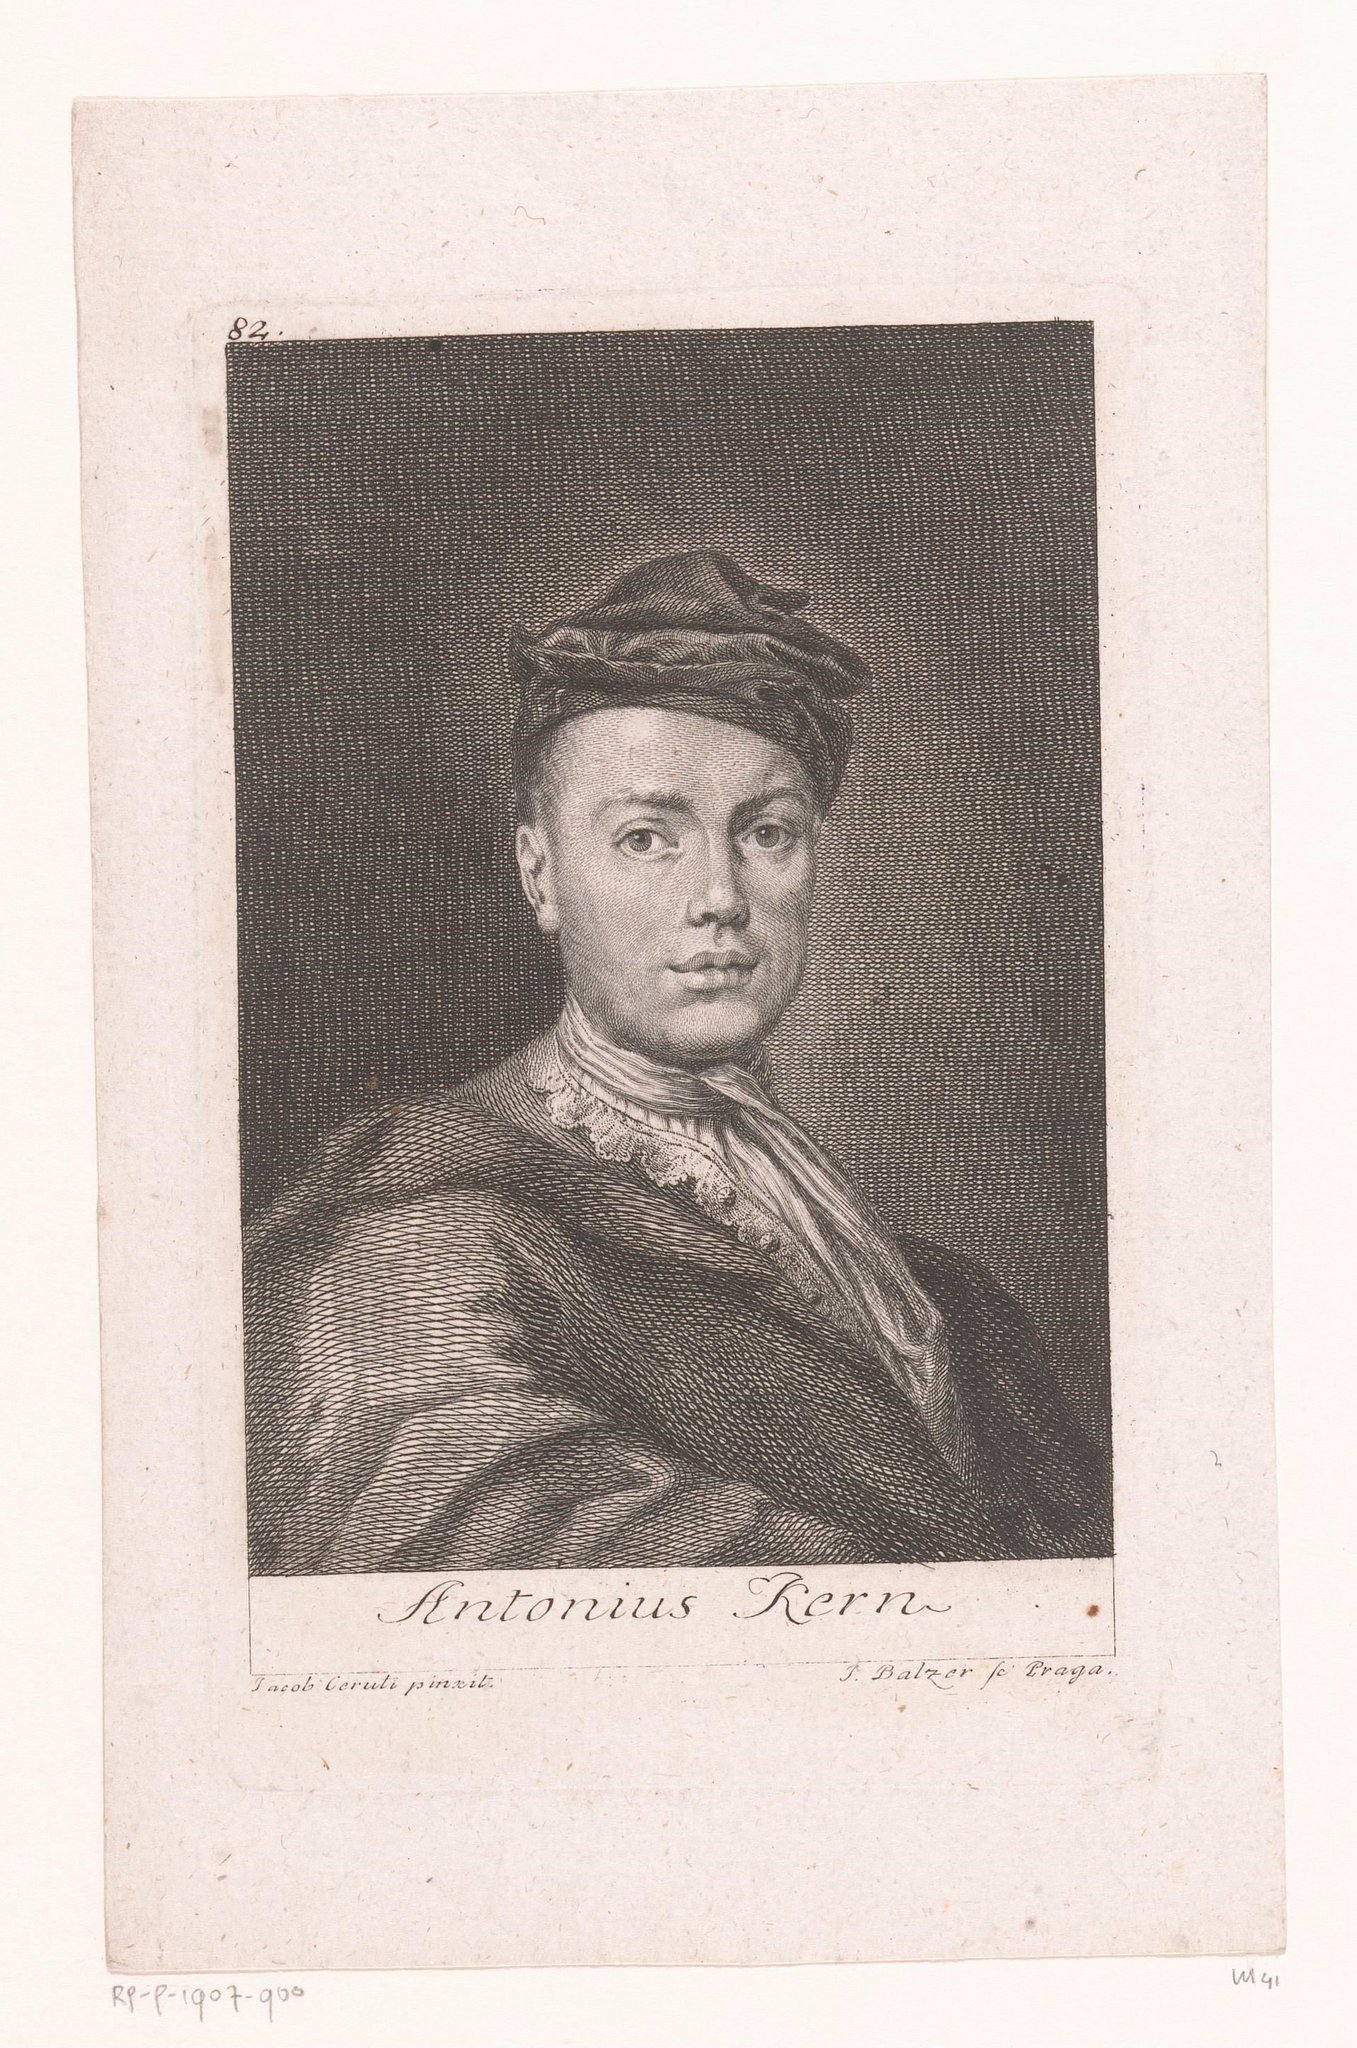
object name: print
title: Portret van kunstenaar Anton Kern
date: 1746-1799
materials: paper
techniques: engraving, etching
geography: prague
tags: painter, anton kern, historical persons, portrait, self-portrait of artist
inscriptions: collector's mark: Lugt 2228